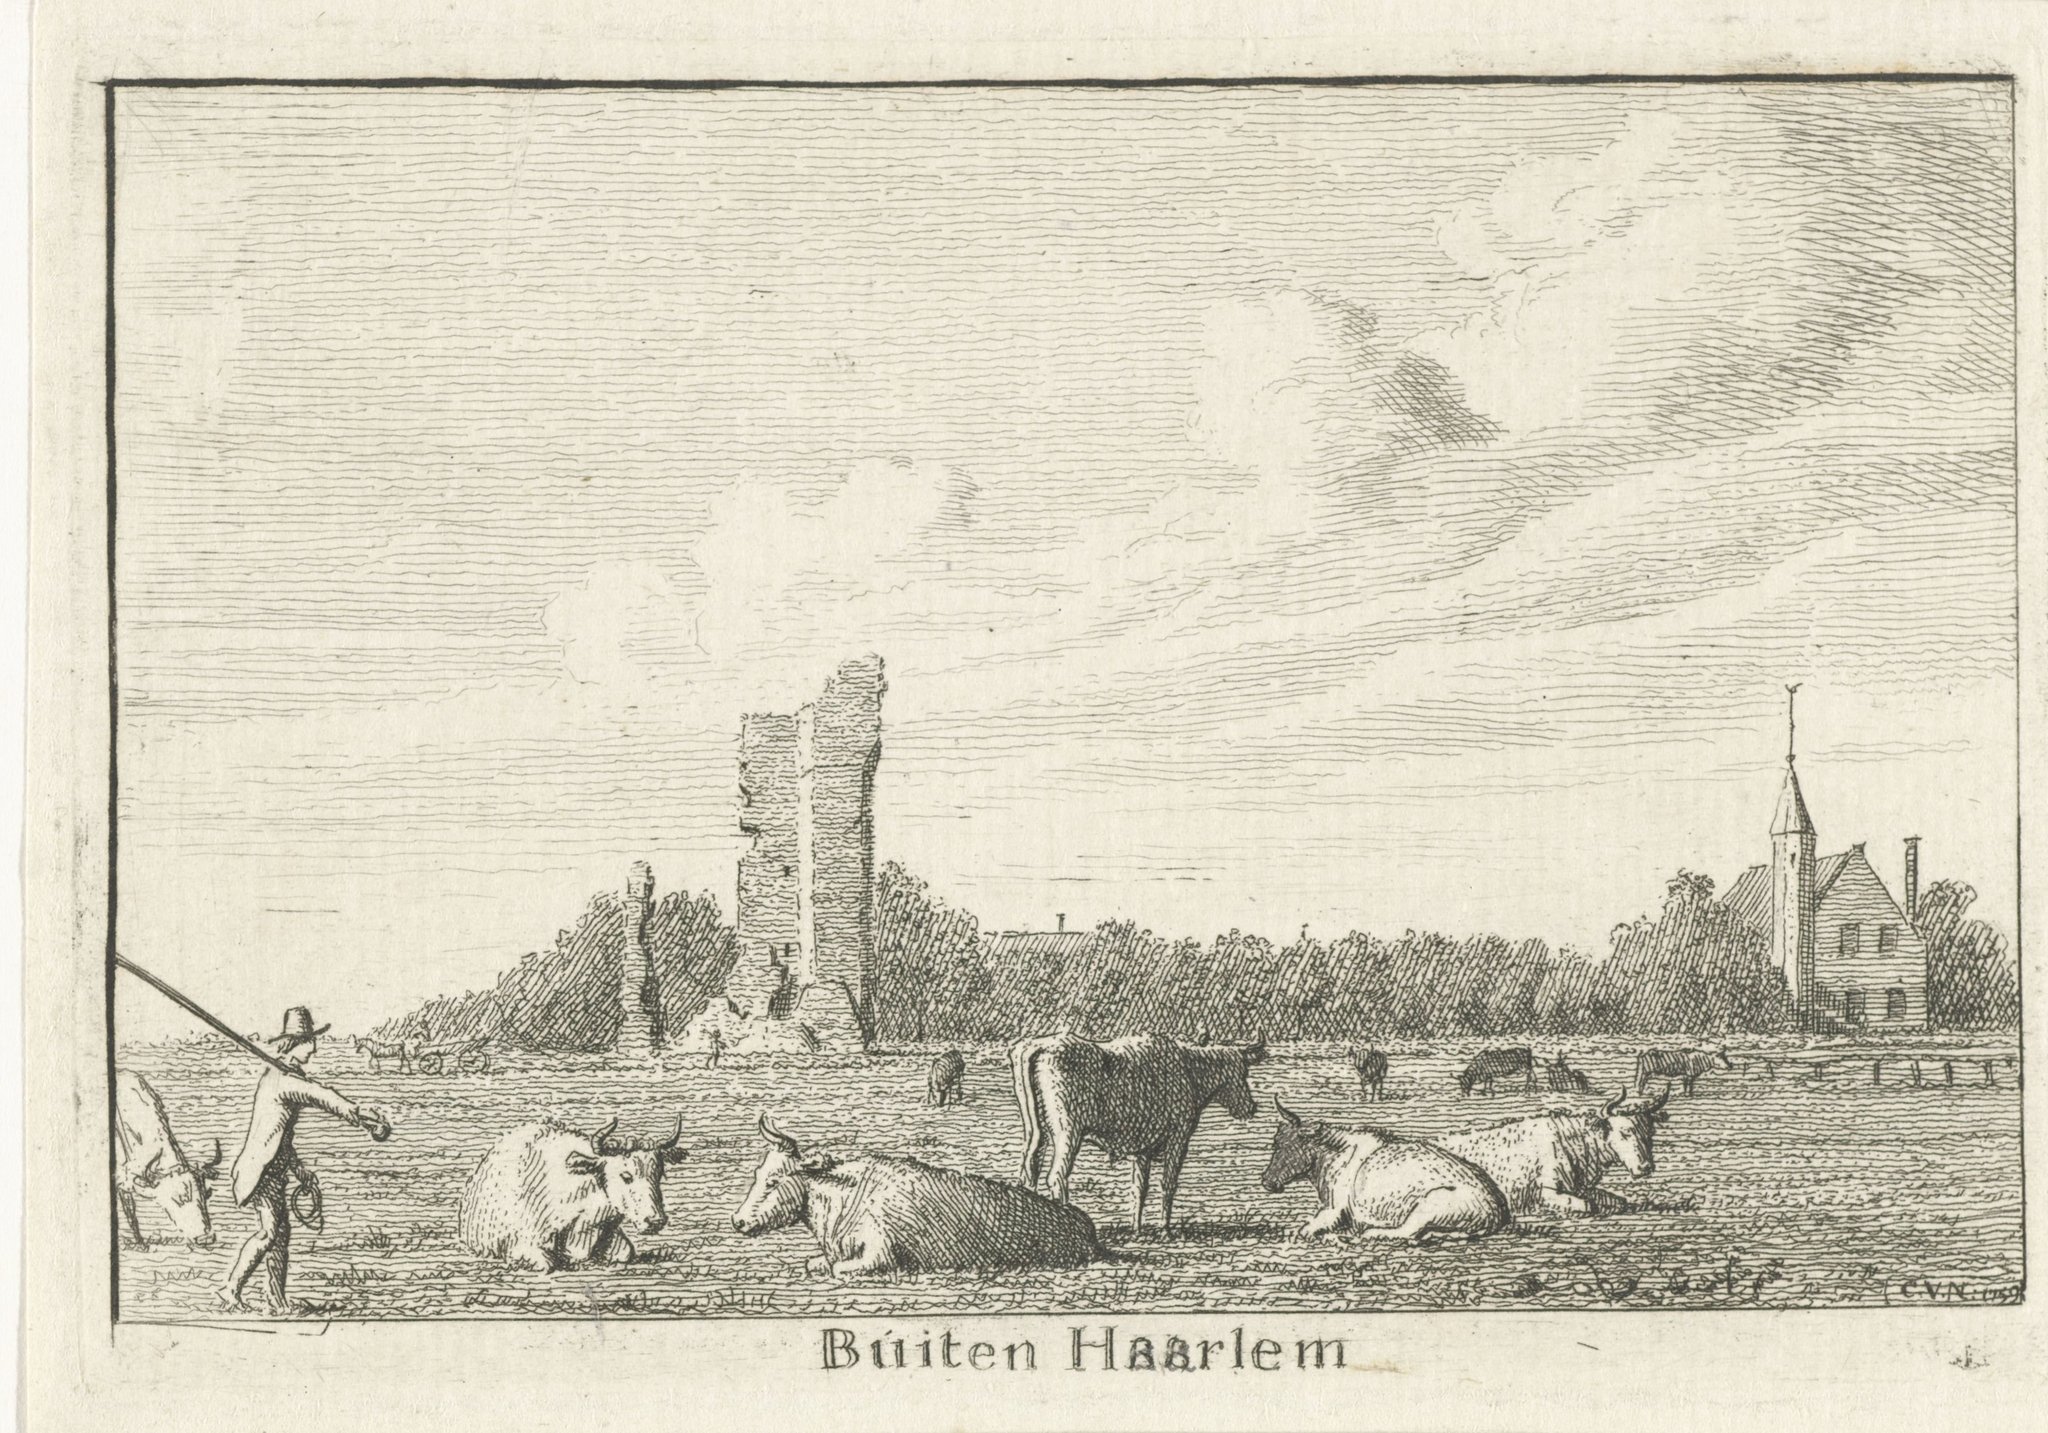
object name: print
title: Weiland met zicht op de ruïne van Huis ter Kleef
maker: cornelis van noorde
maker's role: draughtsman, print maker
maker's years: 1731-1795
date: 1759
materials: paper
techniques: etching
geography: haarlem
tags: cow, ruin of a building ~ architecture, meadow, pasture, church (exterior)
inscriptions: collector's mark: Lugt 2228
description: Een weiland met koeien en een boer buiten Haarlem met zicht op de ruïne van Huis ter Kleef.